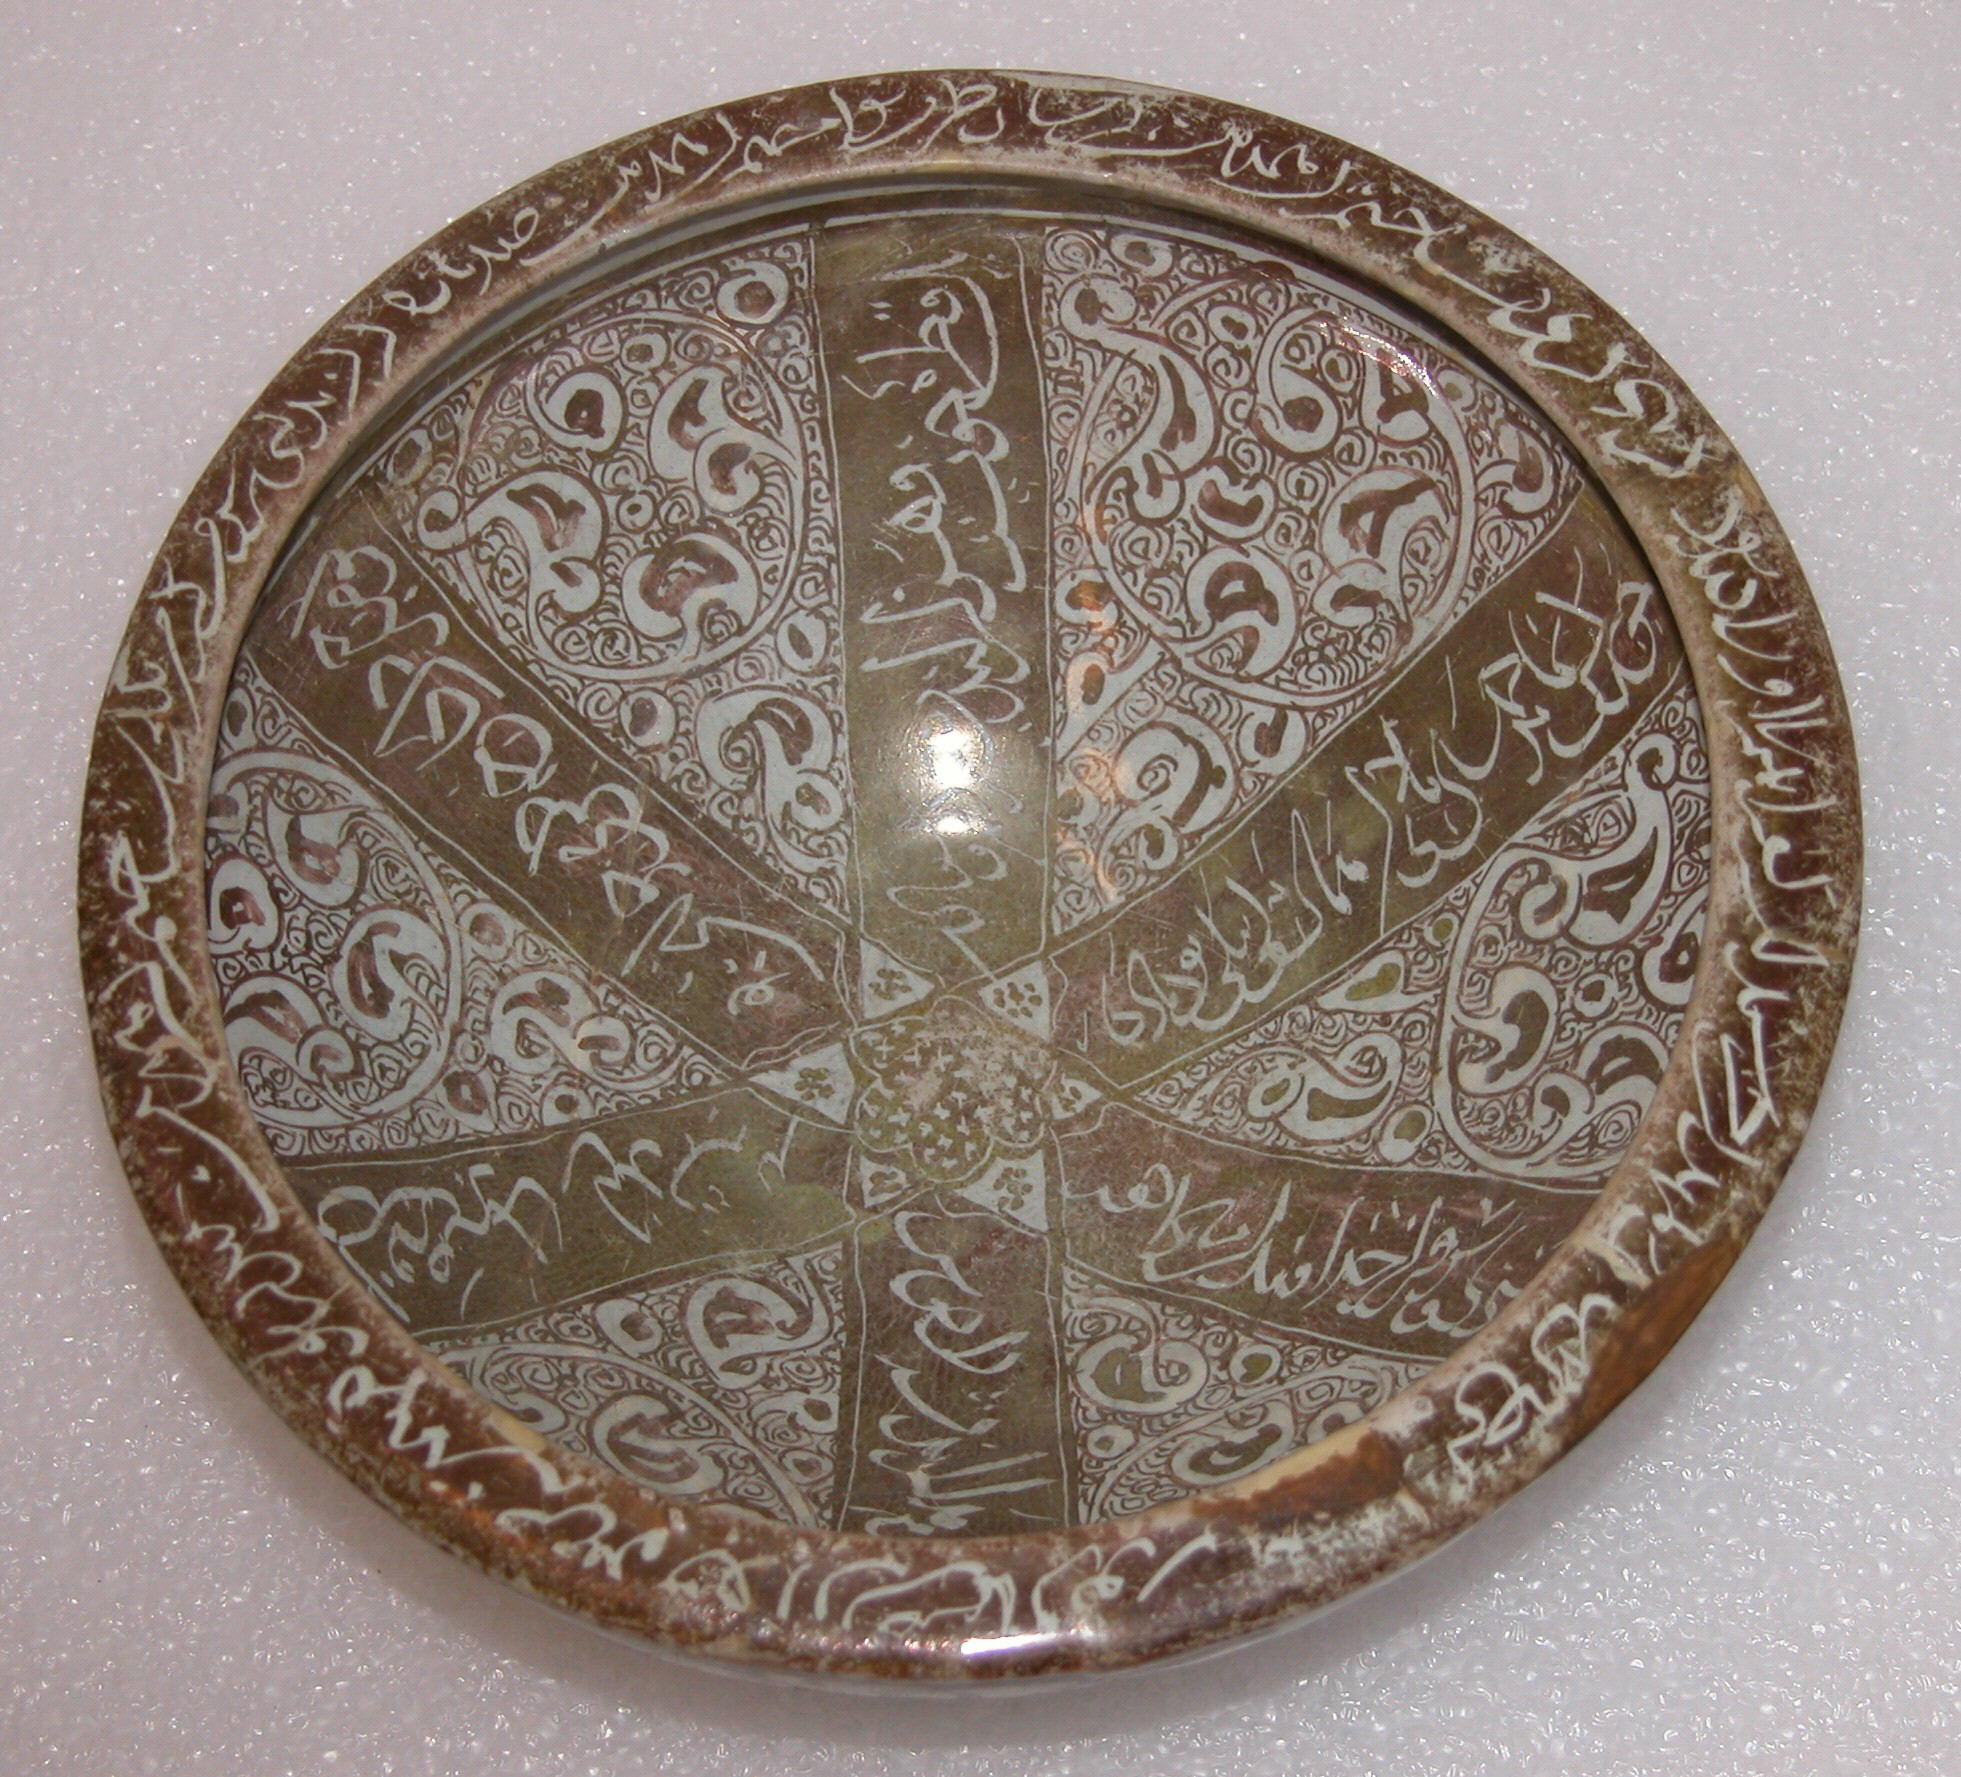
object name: bowl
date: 1251-1300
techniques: glazing, luster painting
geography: iran